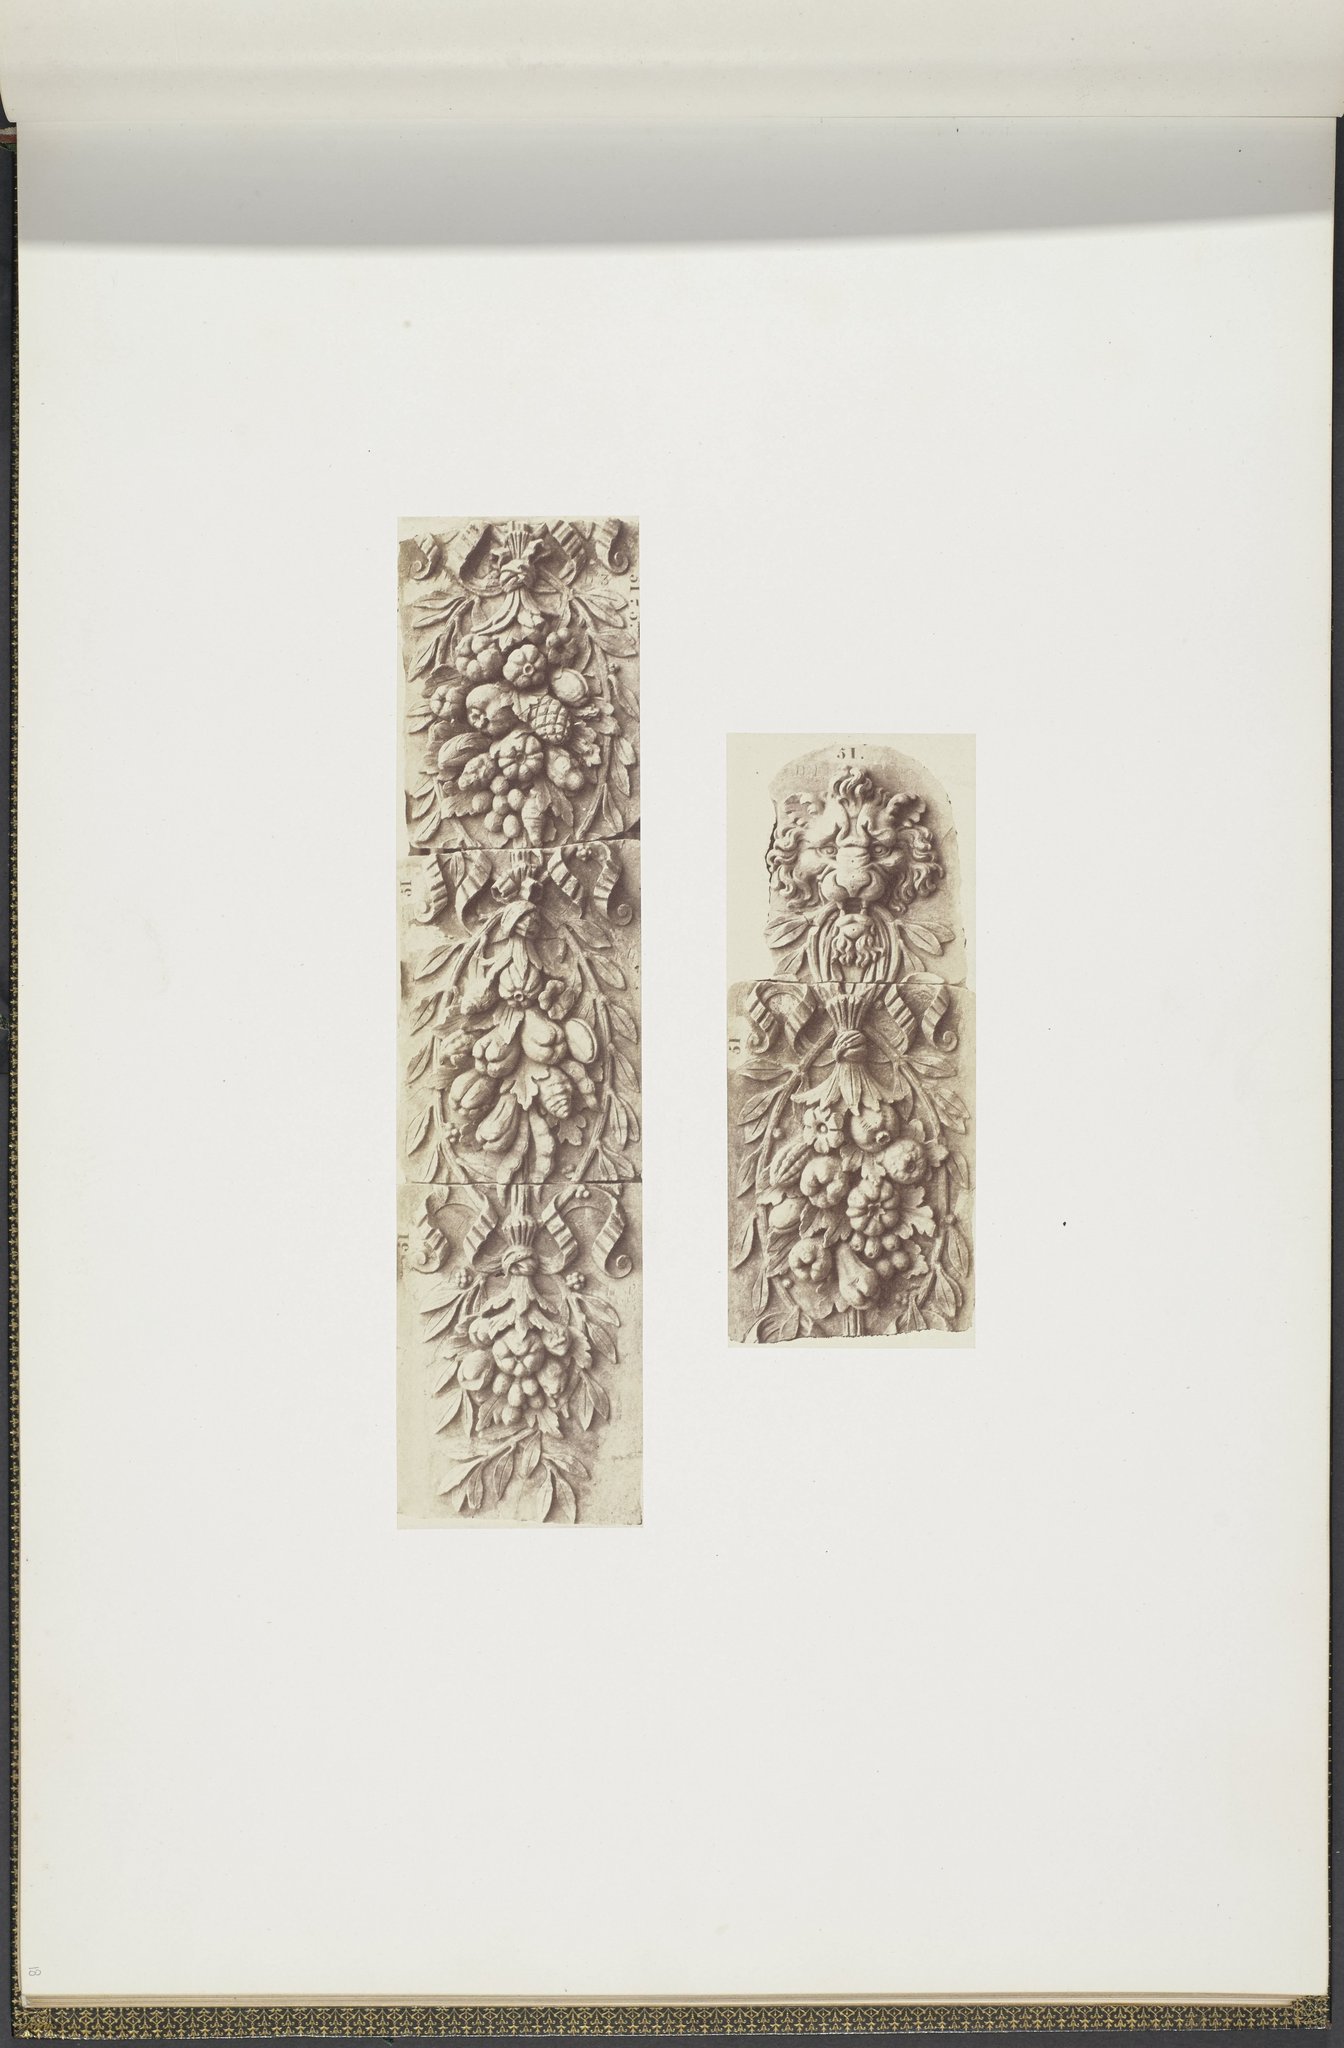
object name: album leaf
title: Details van de versiering op de eerste etage van het Palais de Rohan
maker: édouard denis baldus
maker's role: fotograaf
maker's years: 1813-1889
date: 1855-1857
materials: paper, photographic support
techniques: salted paper print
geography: paris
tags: permanent exhibition, museum, ornamenting, decorating ~ applied arts, paris, tuileries palace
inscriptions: number: ‘51’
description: Onderdeel van Réunion des Tuileries au Louvre 1852-1857, album 1.